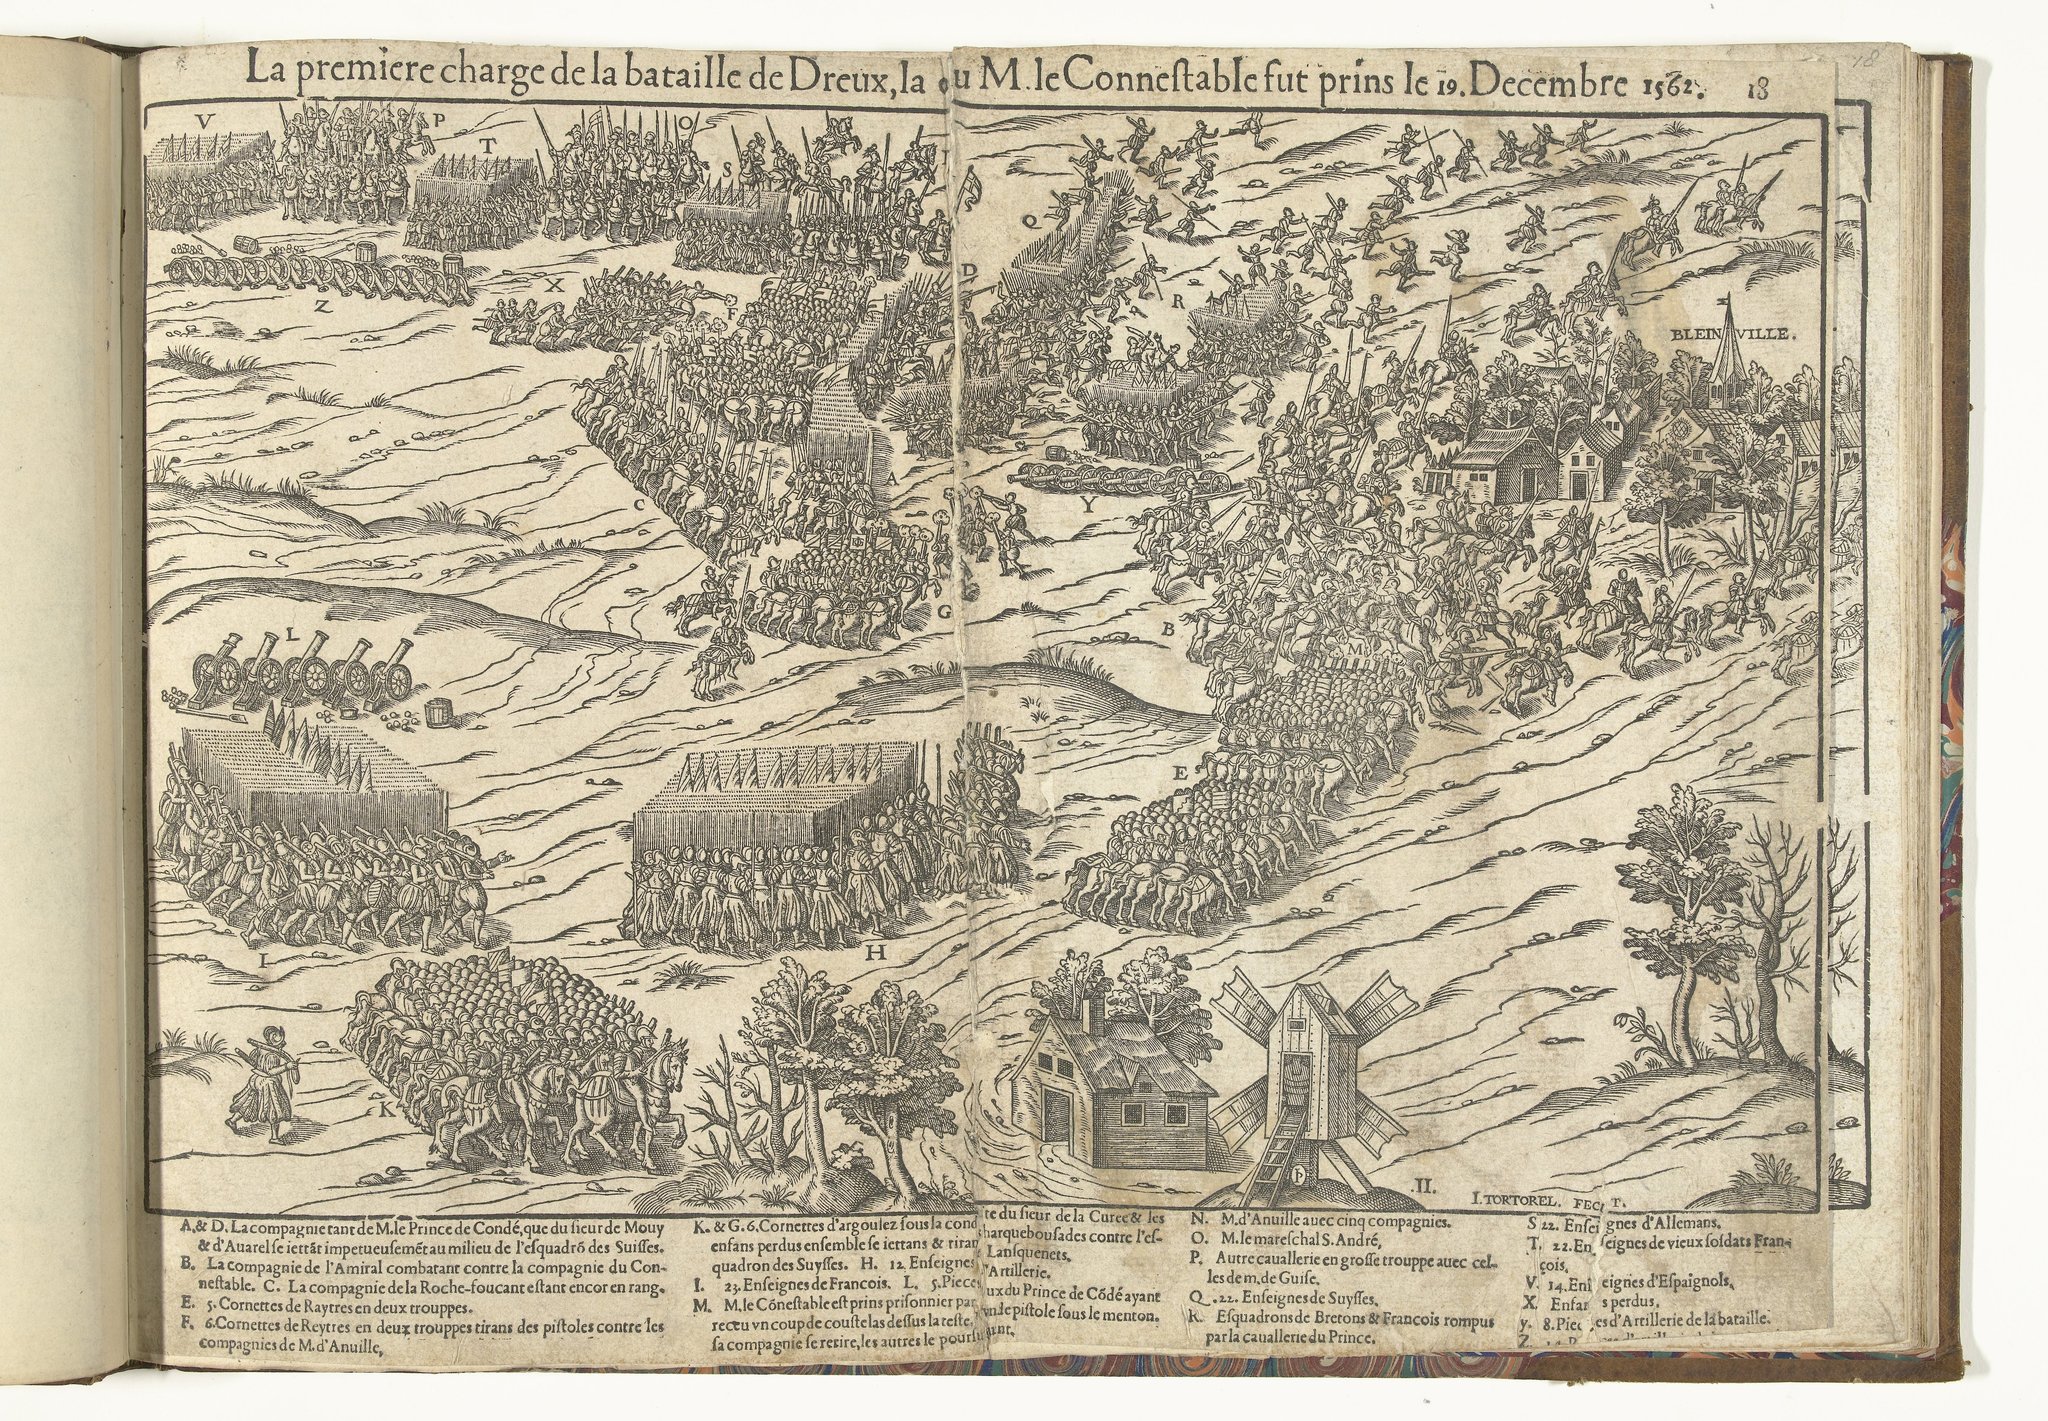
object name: print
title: Slag bij Dreux, eerste treffen, 1562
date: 1570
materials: paper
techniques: letterpress printing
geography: france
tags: battle, fighting in general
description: Slag bij Dreux tussen de hugenoten en de katholieken, eerste treffen, 19 december 1562. Gezicht op het slagveld. In het onderschrift de legenda A-Z in het Frans. Genummerd: 18.